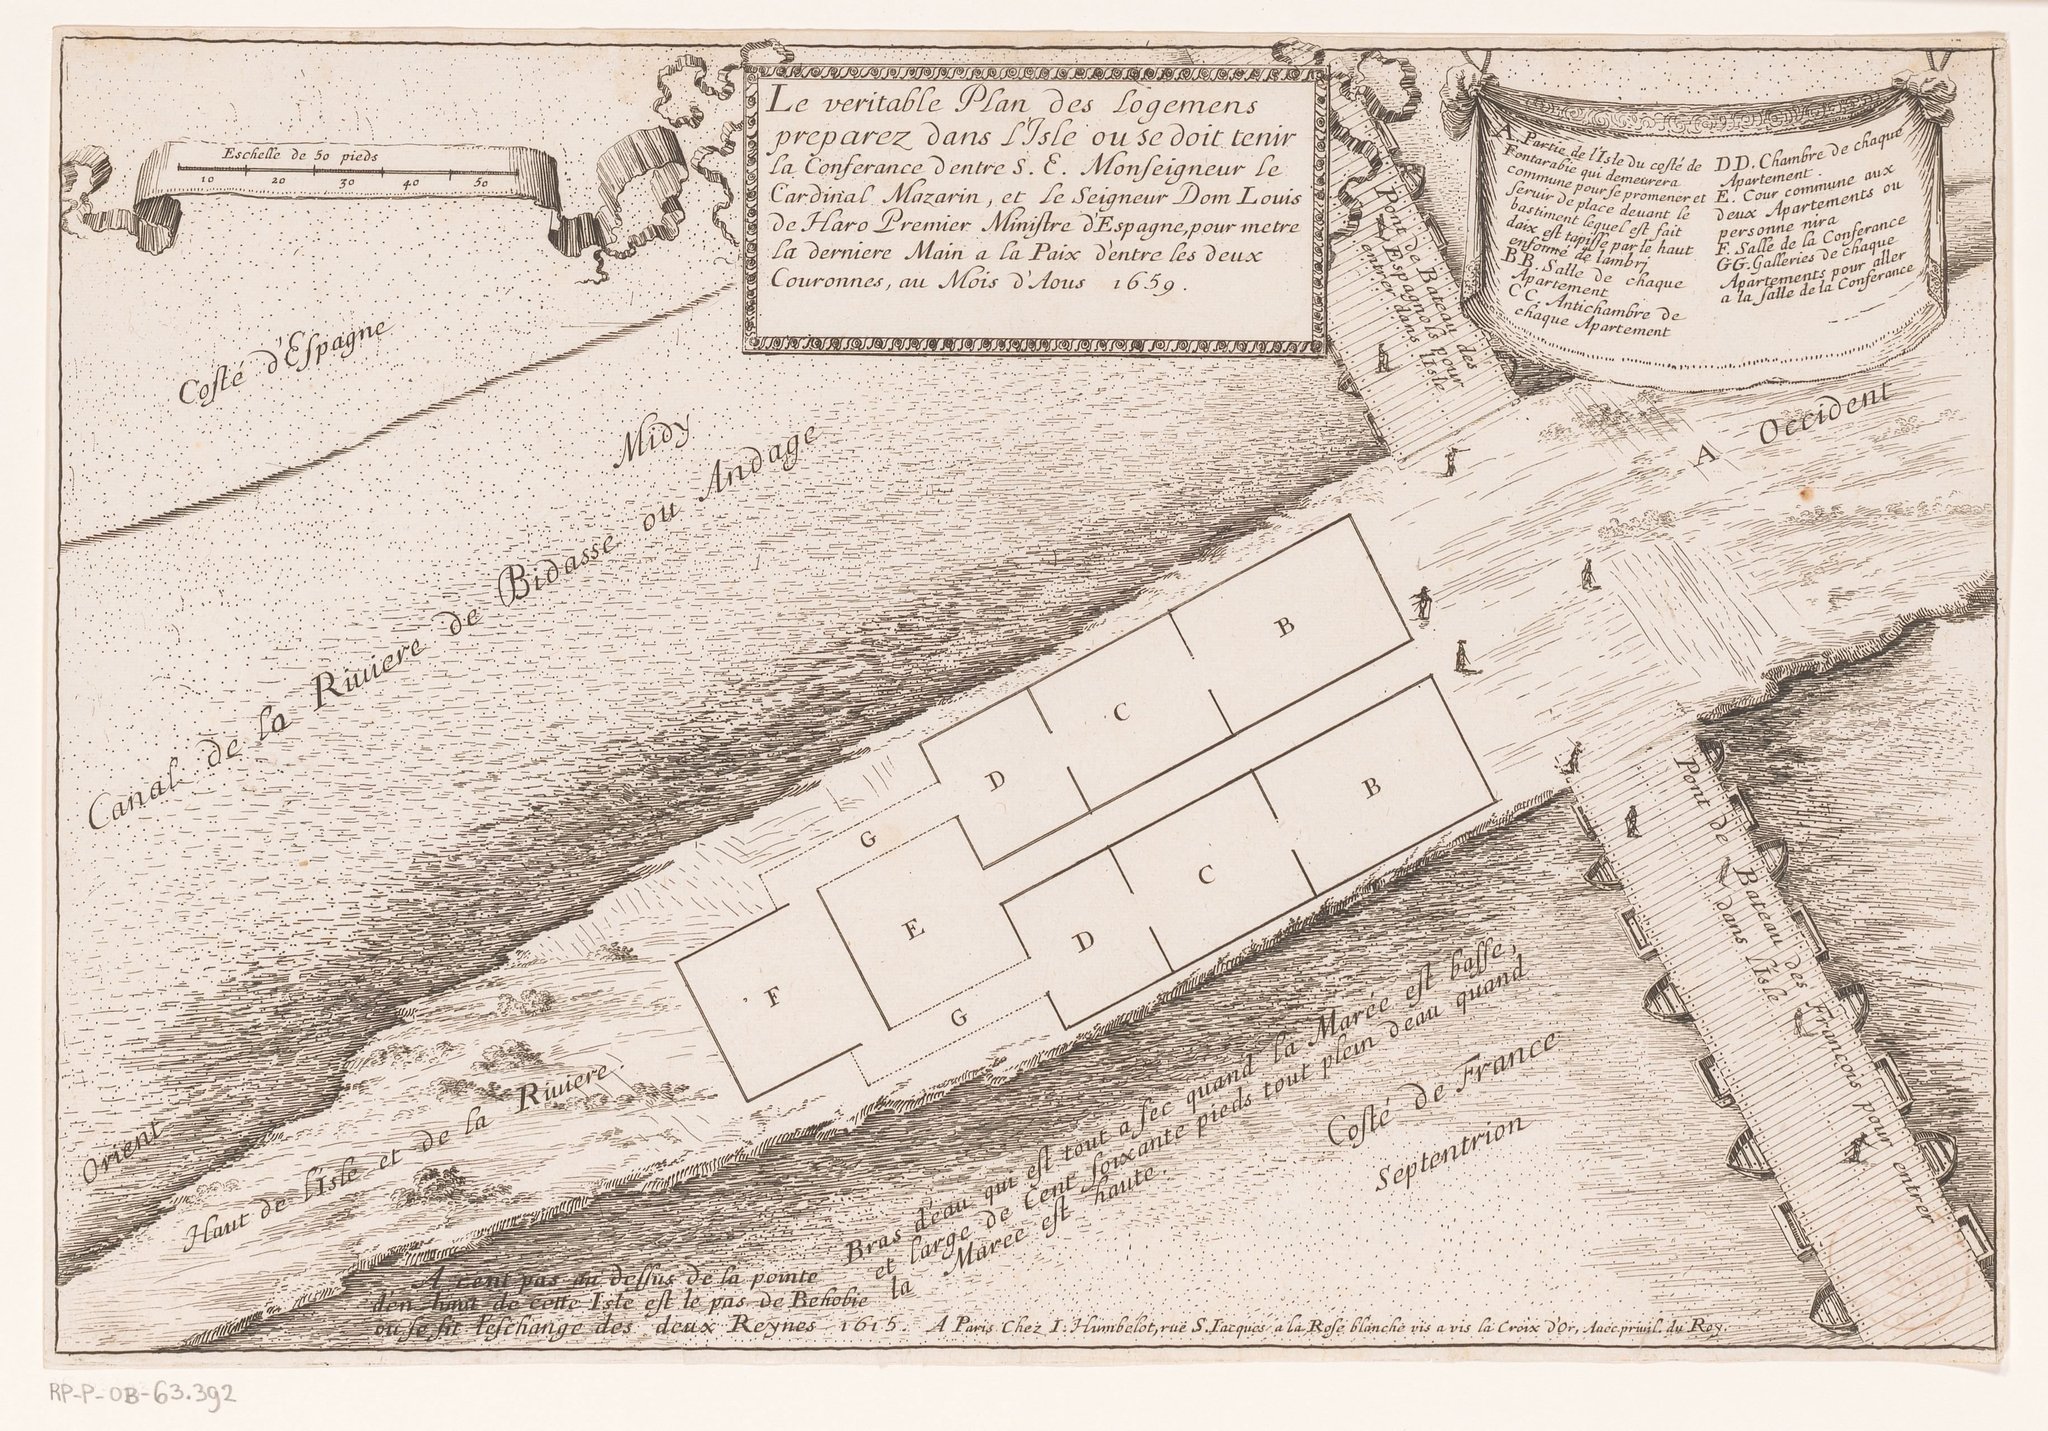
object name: print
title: Plattegrond van de vredesconferentie op het Île des Faisans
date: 1659-1695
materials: paper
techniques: etching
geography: paris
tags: peace negotiations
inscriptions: collector's mark: Lugt 240